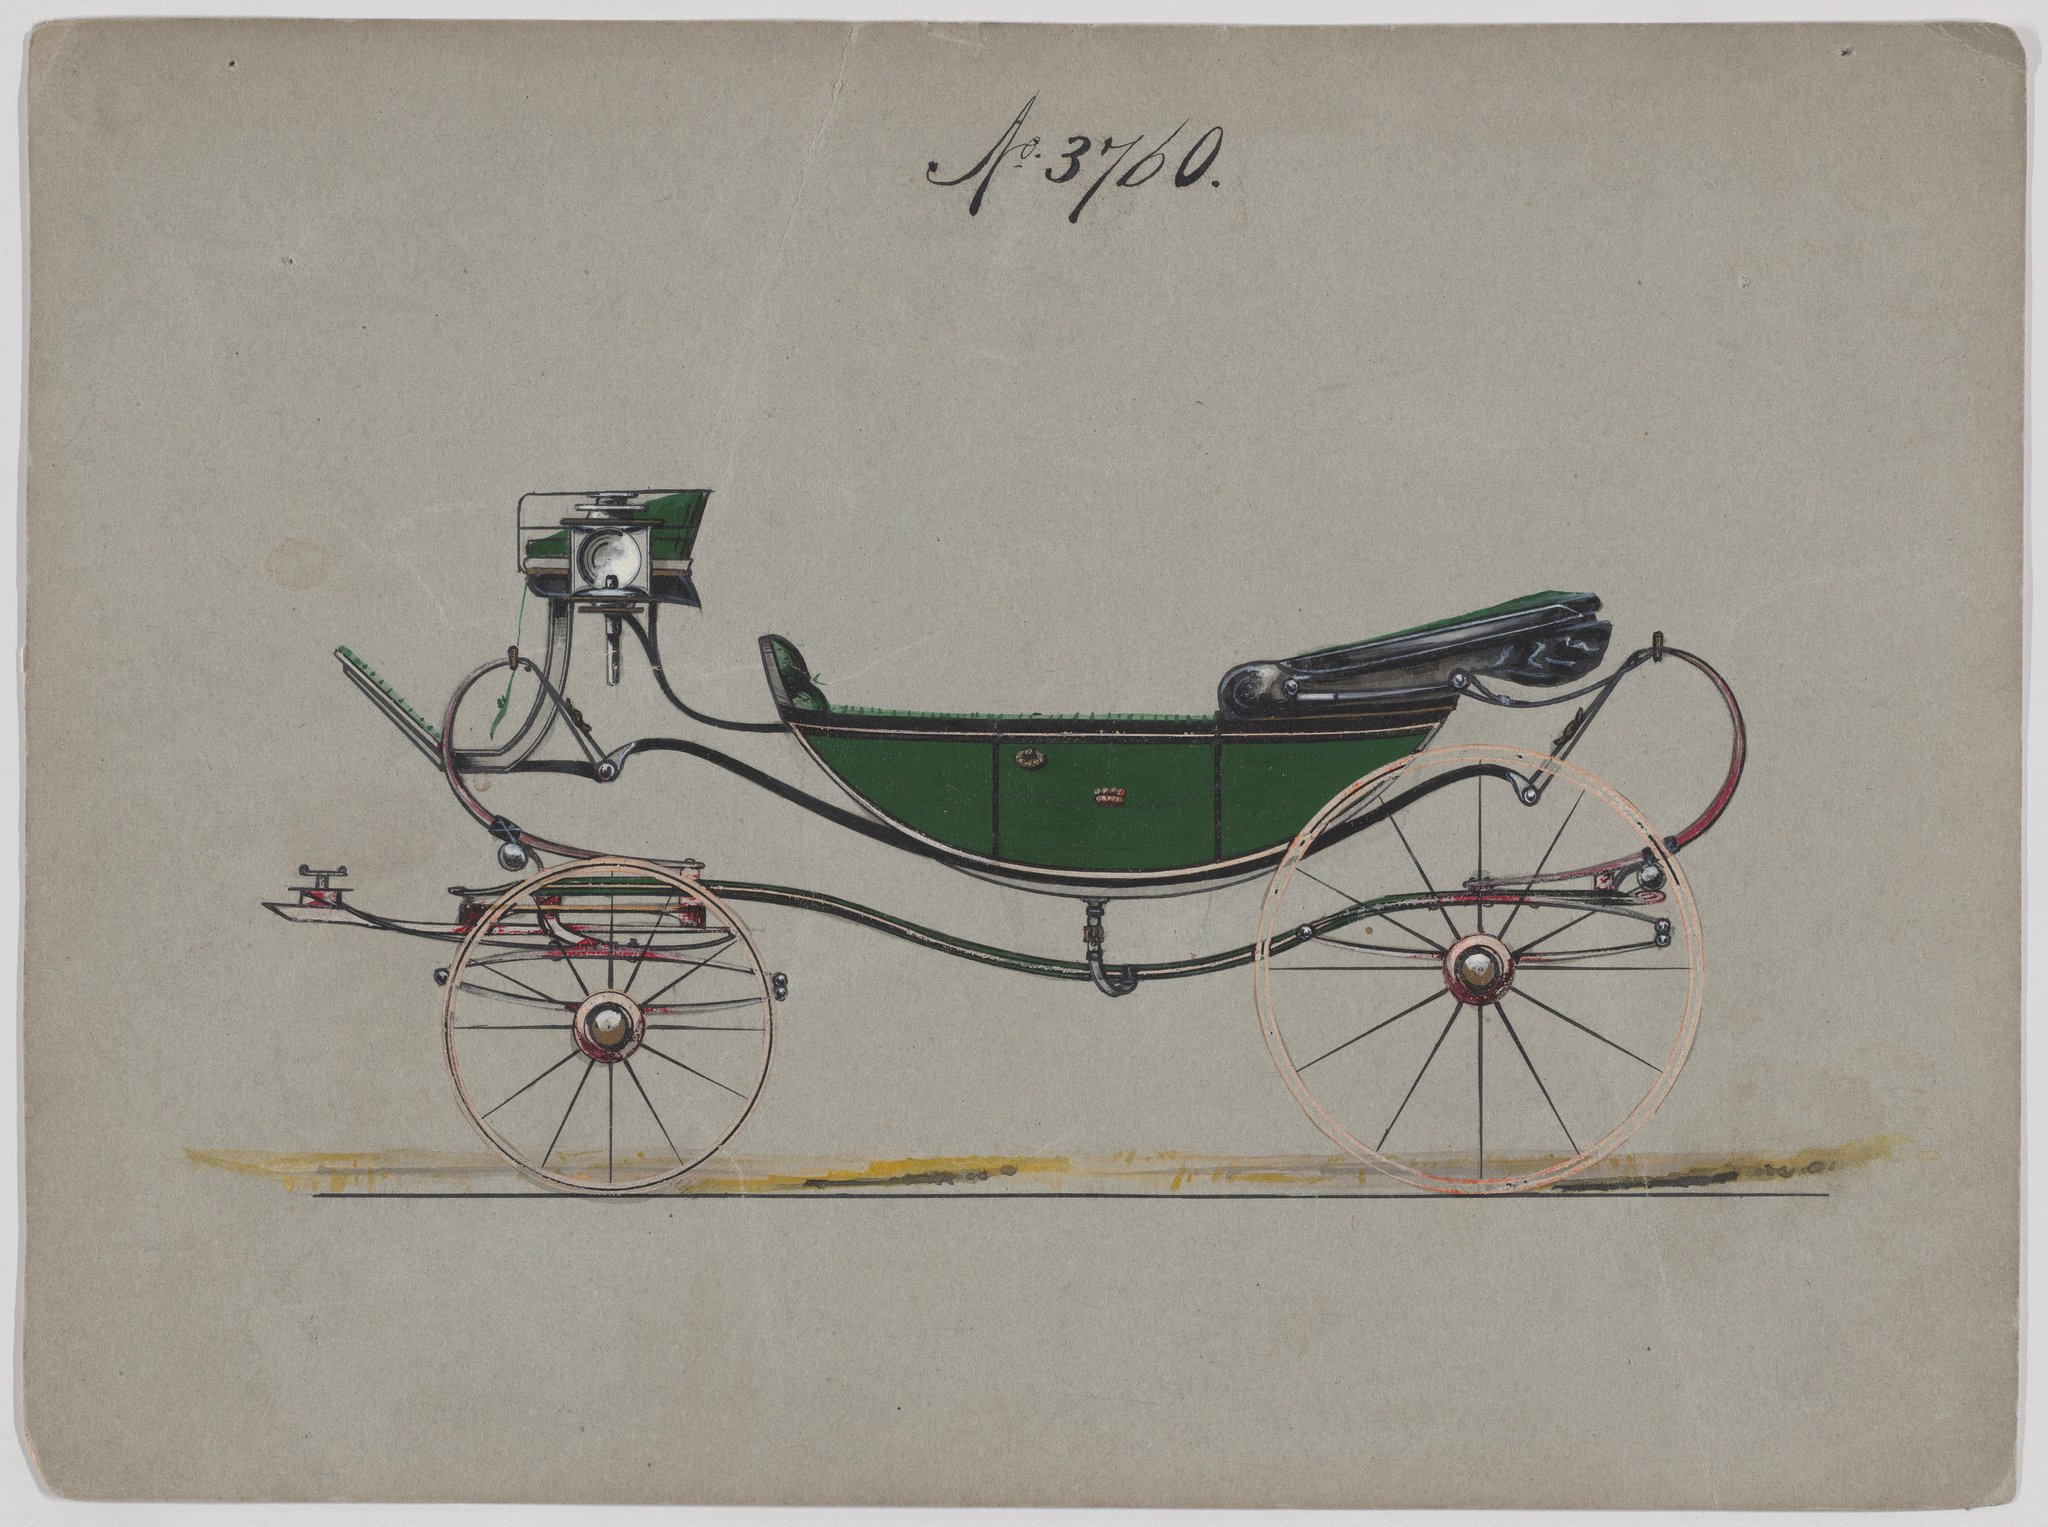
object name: drawing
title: Barouche #3760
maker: brewster & co.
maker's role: manufacturer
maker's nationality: american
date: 1882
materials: gum arabic, ink, watercolor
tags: carriages